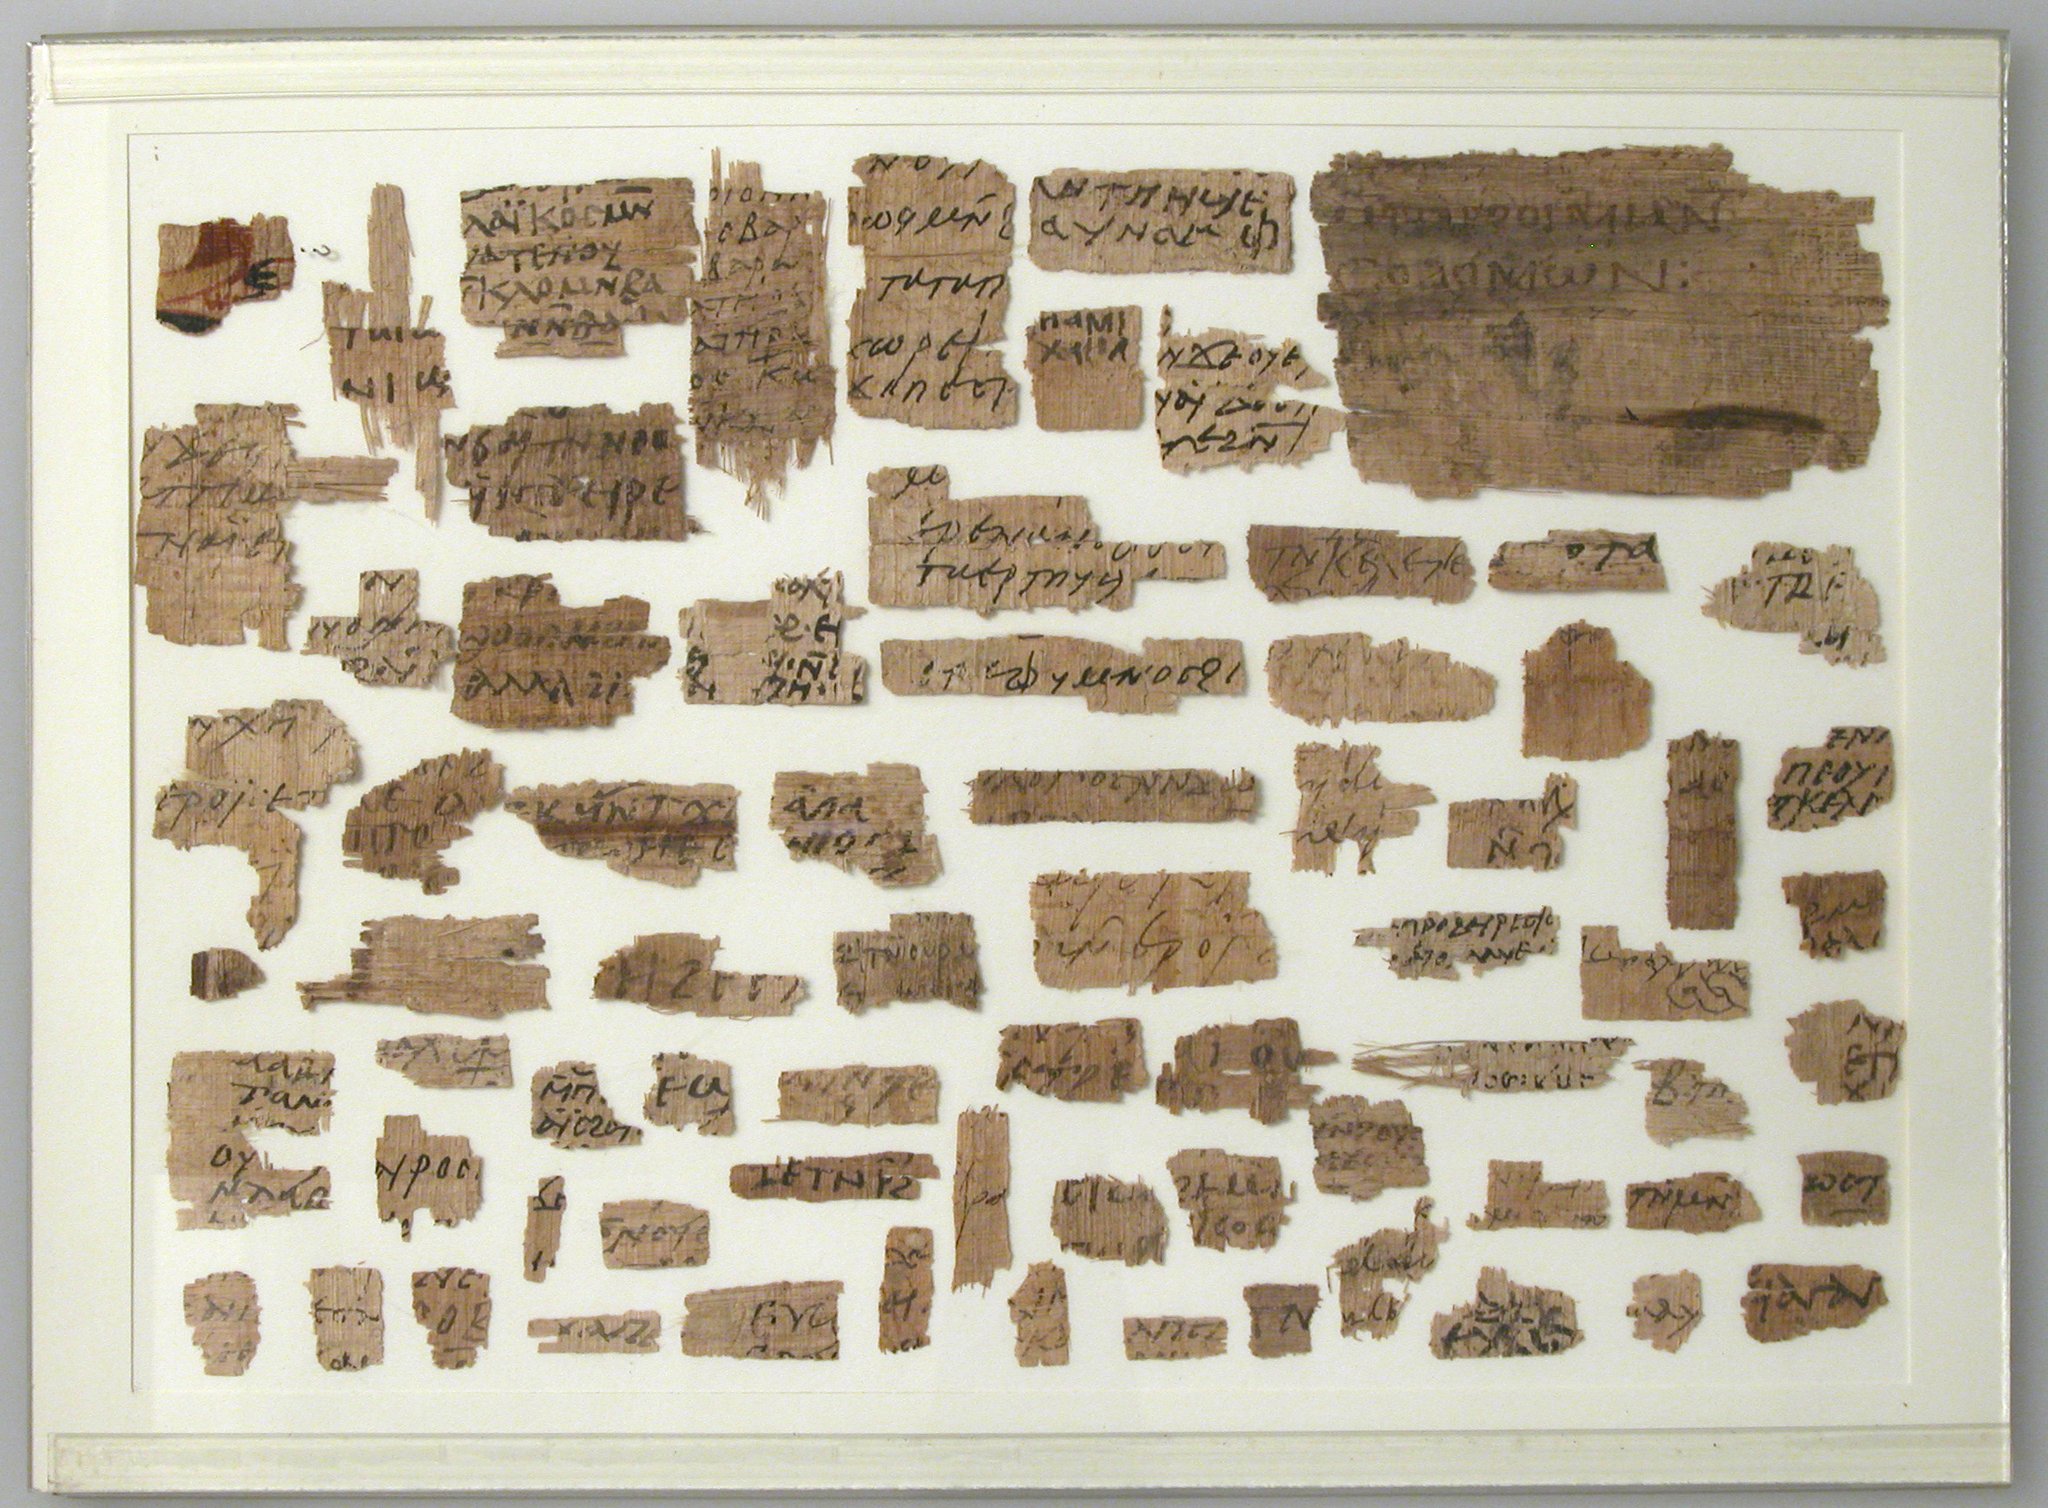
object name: fragment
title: Papyri Fragments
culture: coptic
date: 601-700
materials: ink, papyrus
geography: egypt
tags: documents